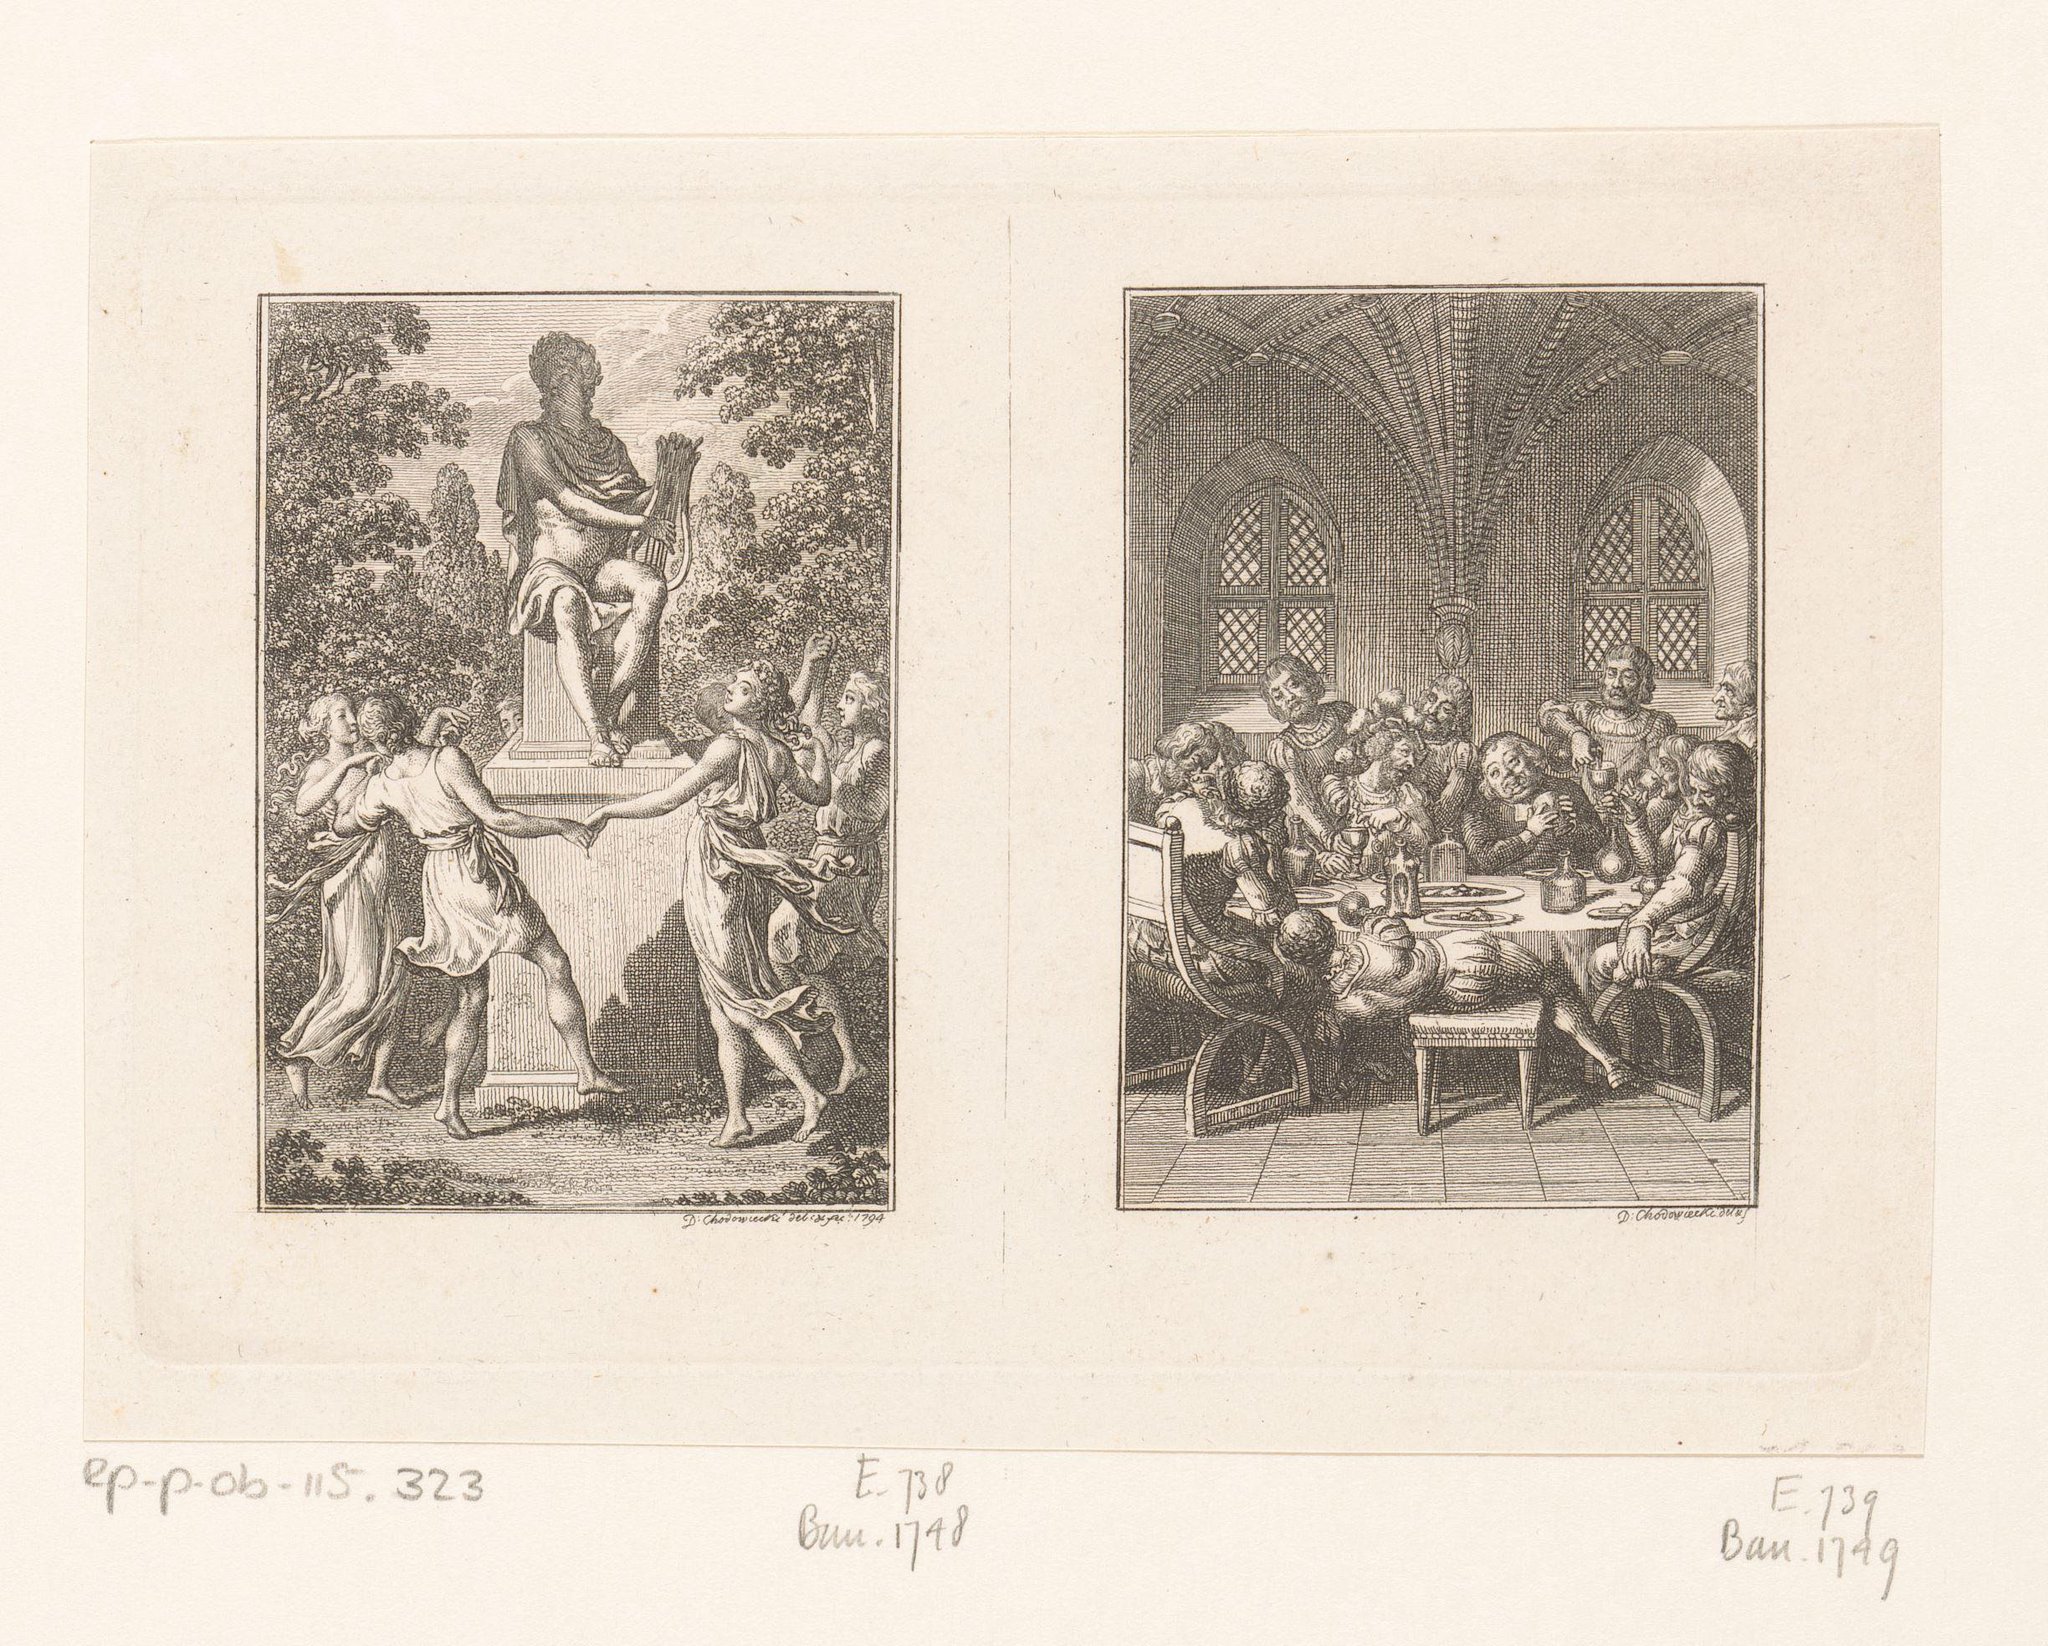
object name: print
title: Twee voorstellingen bij de gedichten van Wilhelm Gottlieb Becker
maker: daniel nikolaus chodowiecki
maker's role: draughtsman, print maker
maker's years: 1726-1801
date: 1794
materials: paper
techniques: etching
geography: berlin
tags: monument, statue, apollo playing the lyre, apollo citharoedus, drunkenness, group dancing around someone or something (folk dancing), celebration meal, feast, banquet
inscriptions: collector's mark: Lugt 2228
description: Latere staat gebruikt voor: Becker, Wilhelm Gottlieb. Taschenbuch und Almanach zum geselligen Vergnügen (...). Leipzig: Voss und Companie, 1795.